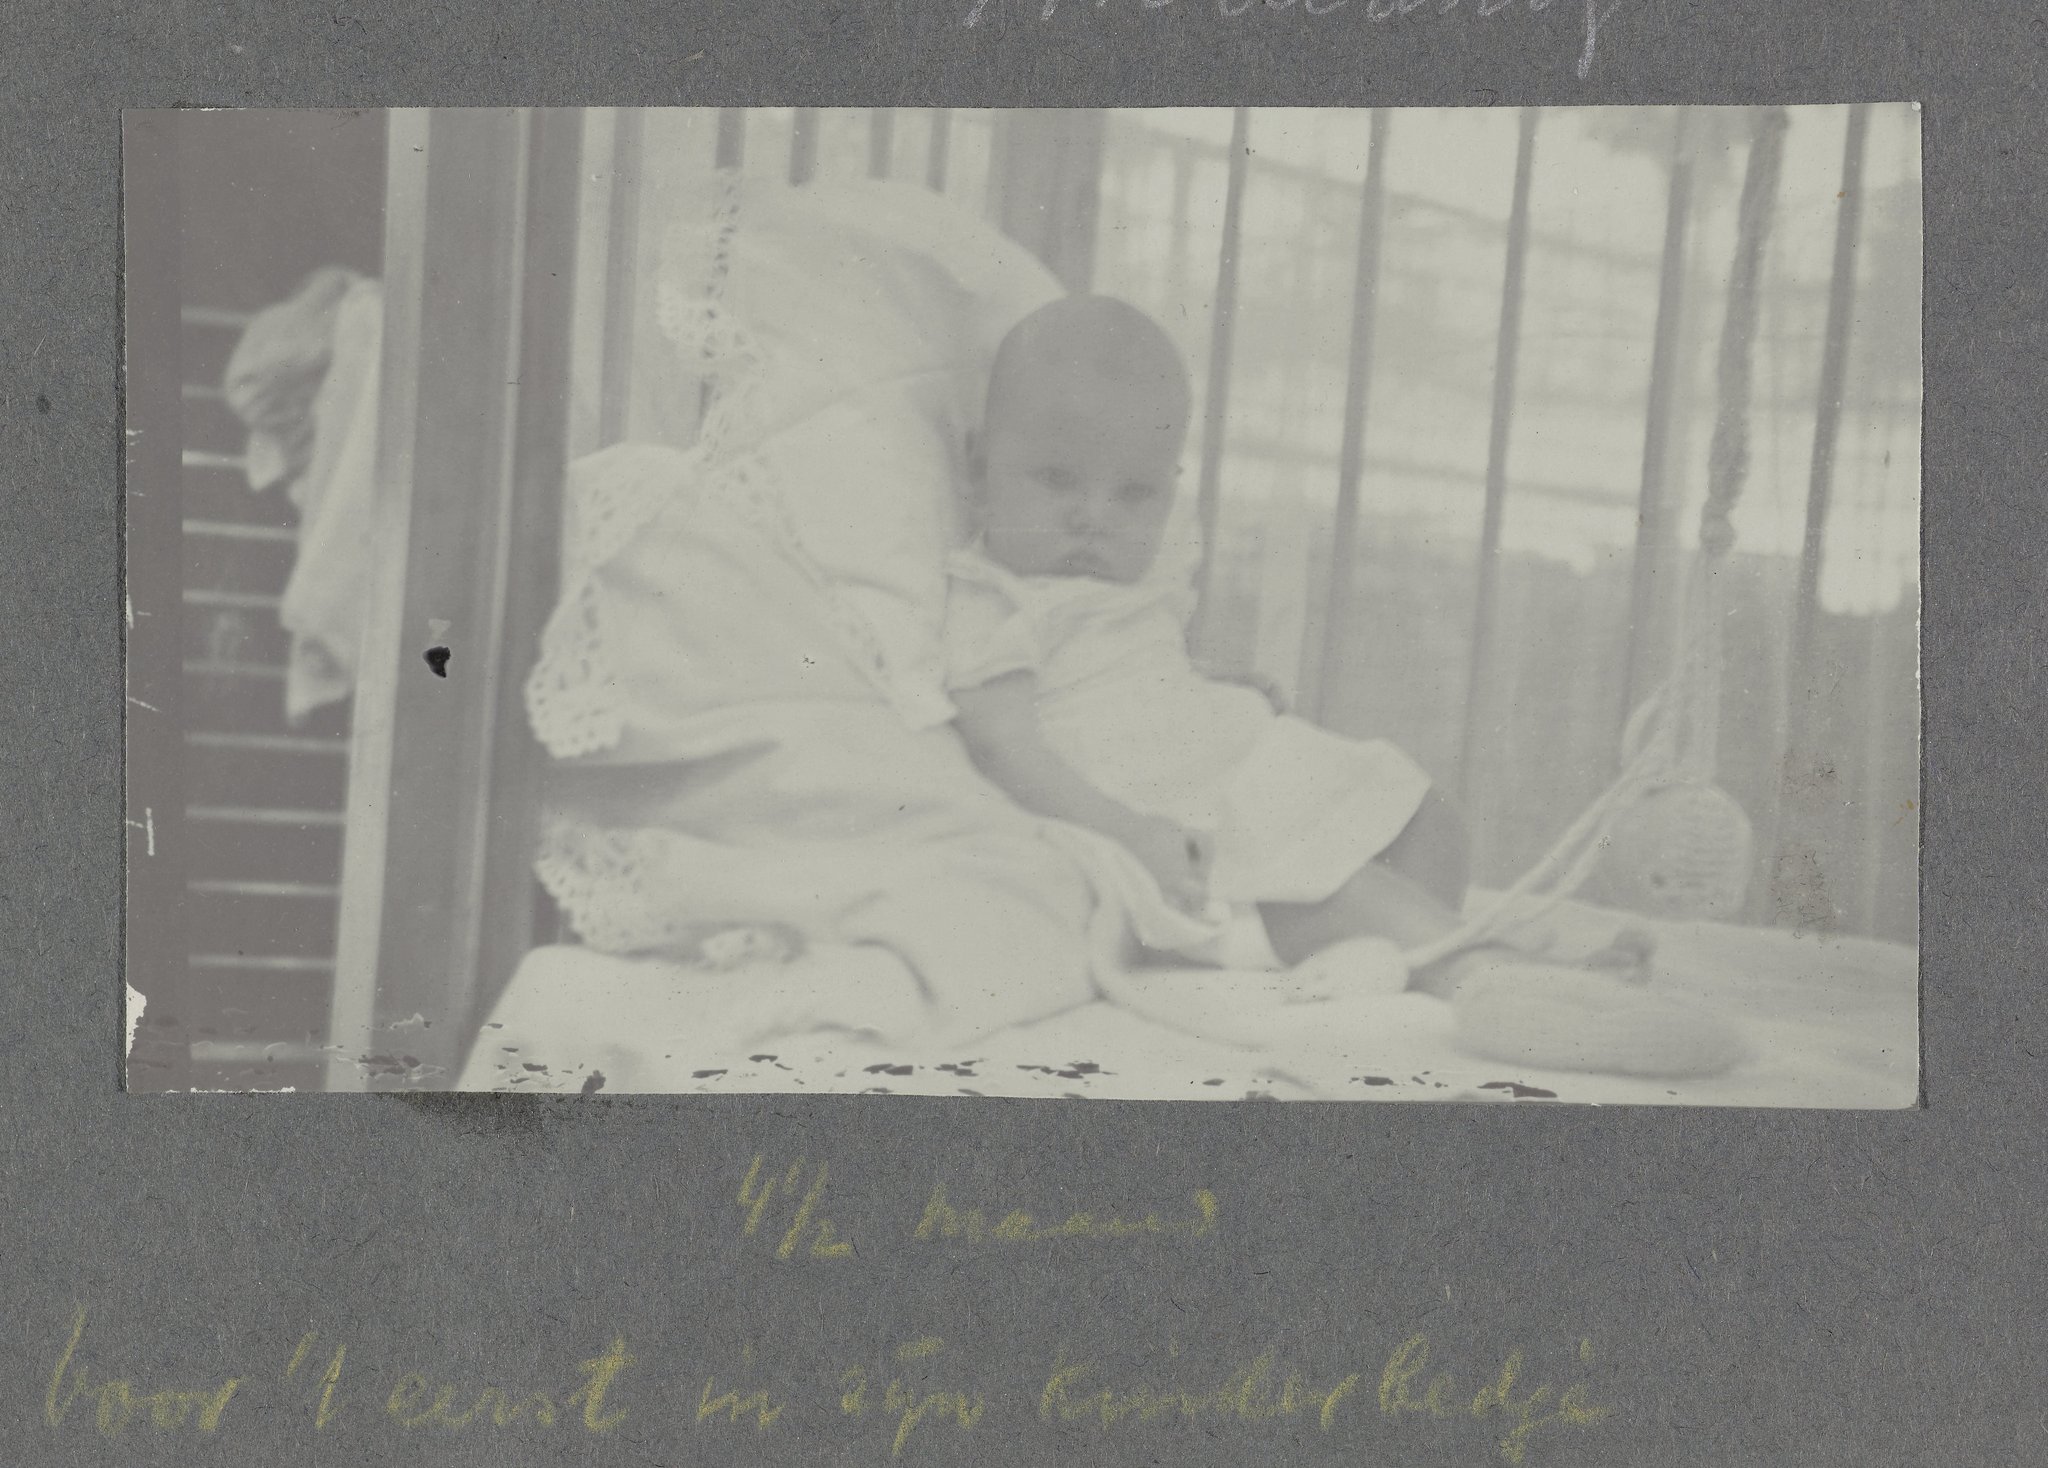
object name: photograph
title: Vier en een halve maand oude baby Klaas Kleiterp voor het eerst in zijn kinderbed in Malang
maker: klaas kleiterp (i)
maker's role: arts, officier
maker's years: 1892-1943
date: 1920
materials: paper, photographic support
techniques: daylight paper print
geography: malang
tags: infant, baby ~ the ages of man, dutch east indies, the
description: Onderdeel van Fotoalbum van de familie Kleiterp-Vermeulen met opnames van de kinderen Klaas en Tiny in Nederlands-Indië.